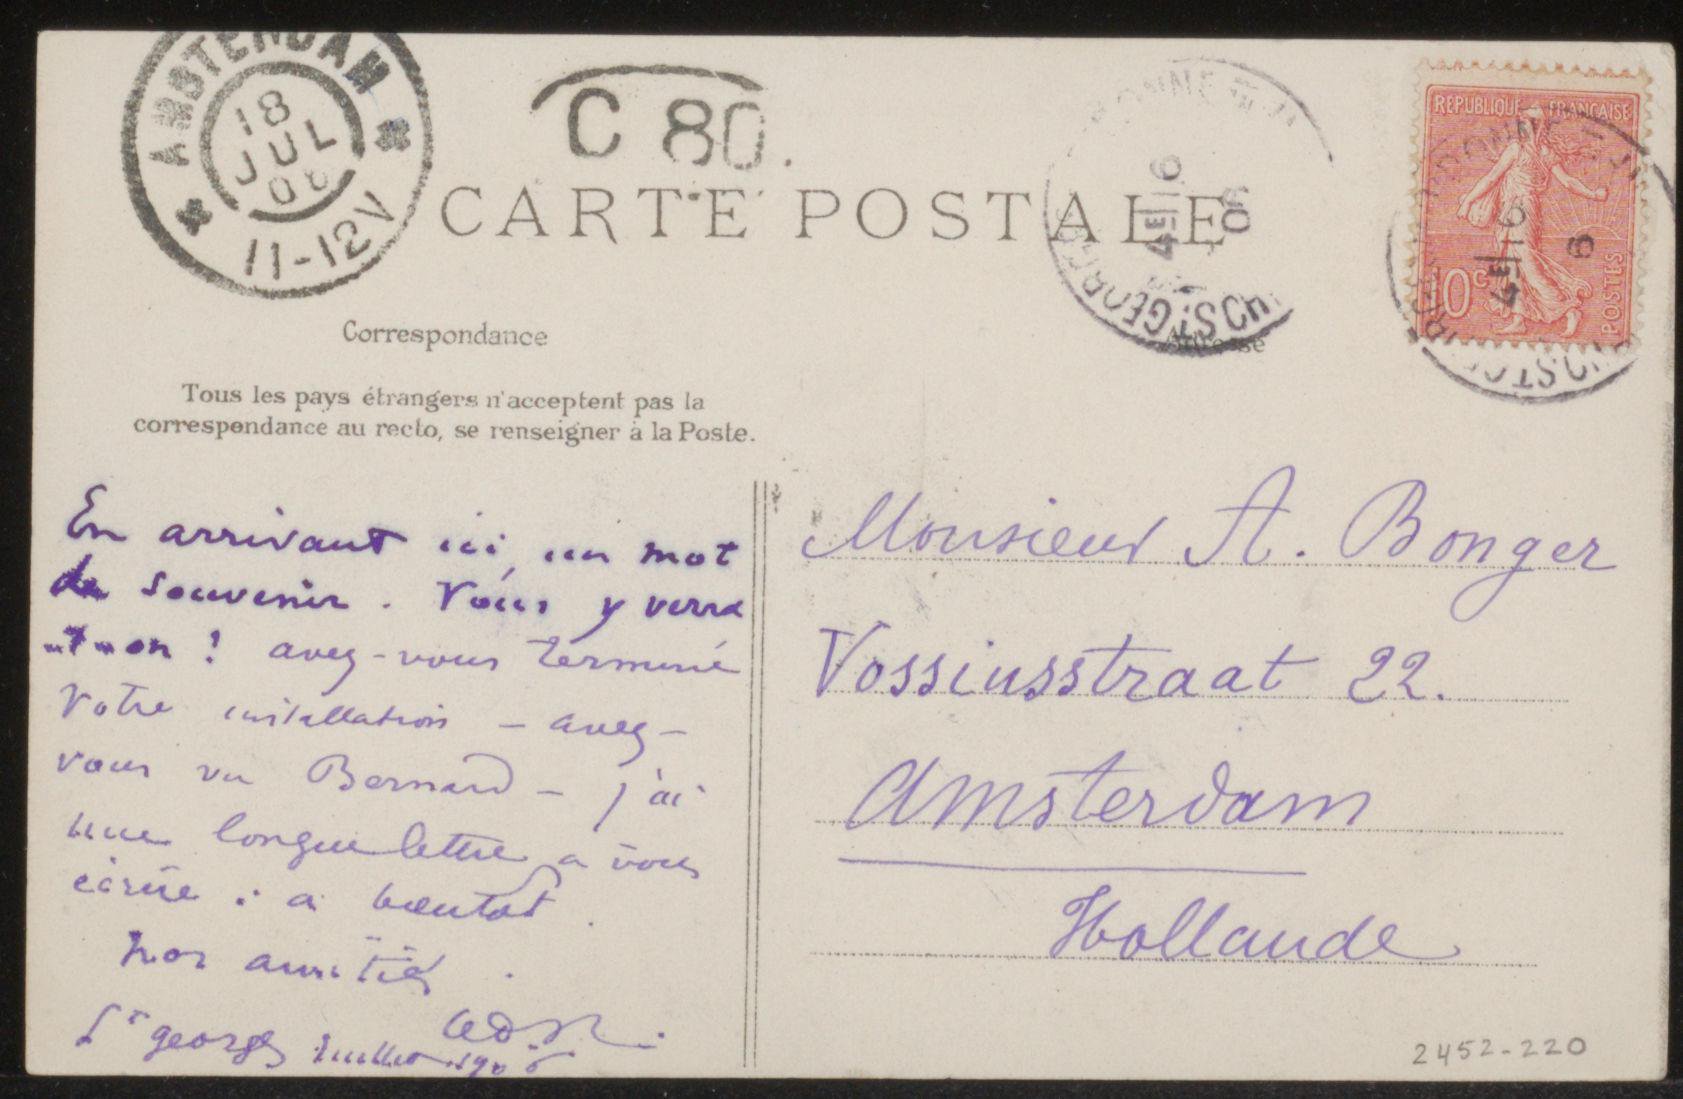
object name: ansichtkaart, prentbriefkaart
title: Prentbriefkaart aan Andries Bonger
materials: cardboard, ink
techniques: photograph, pen, writing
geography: royan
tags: lille, paris, print maker, émile bernard, amsterdam, andries bonger